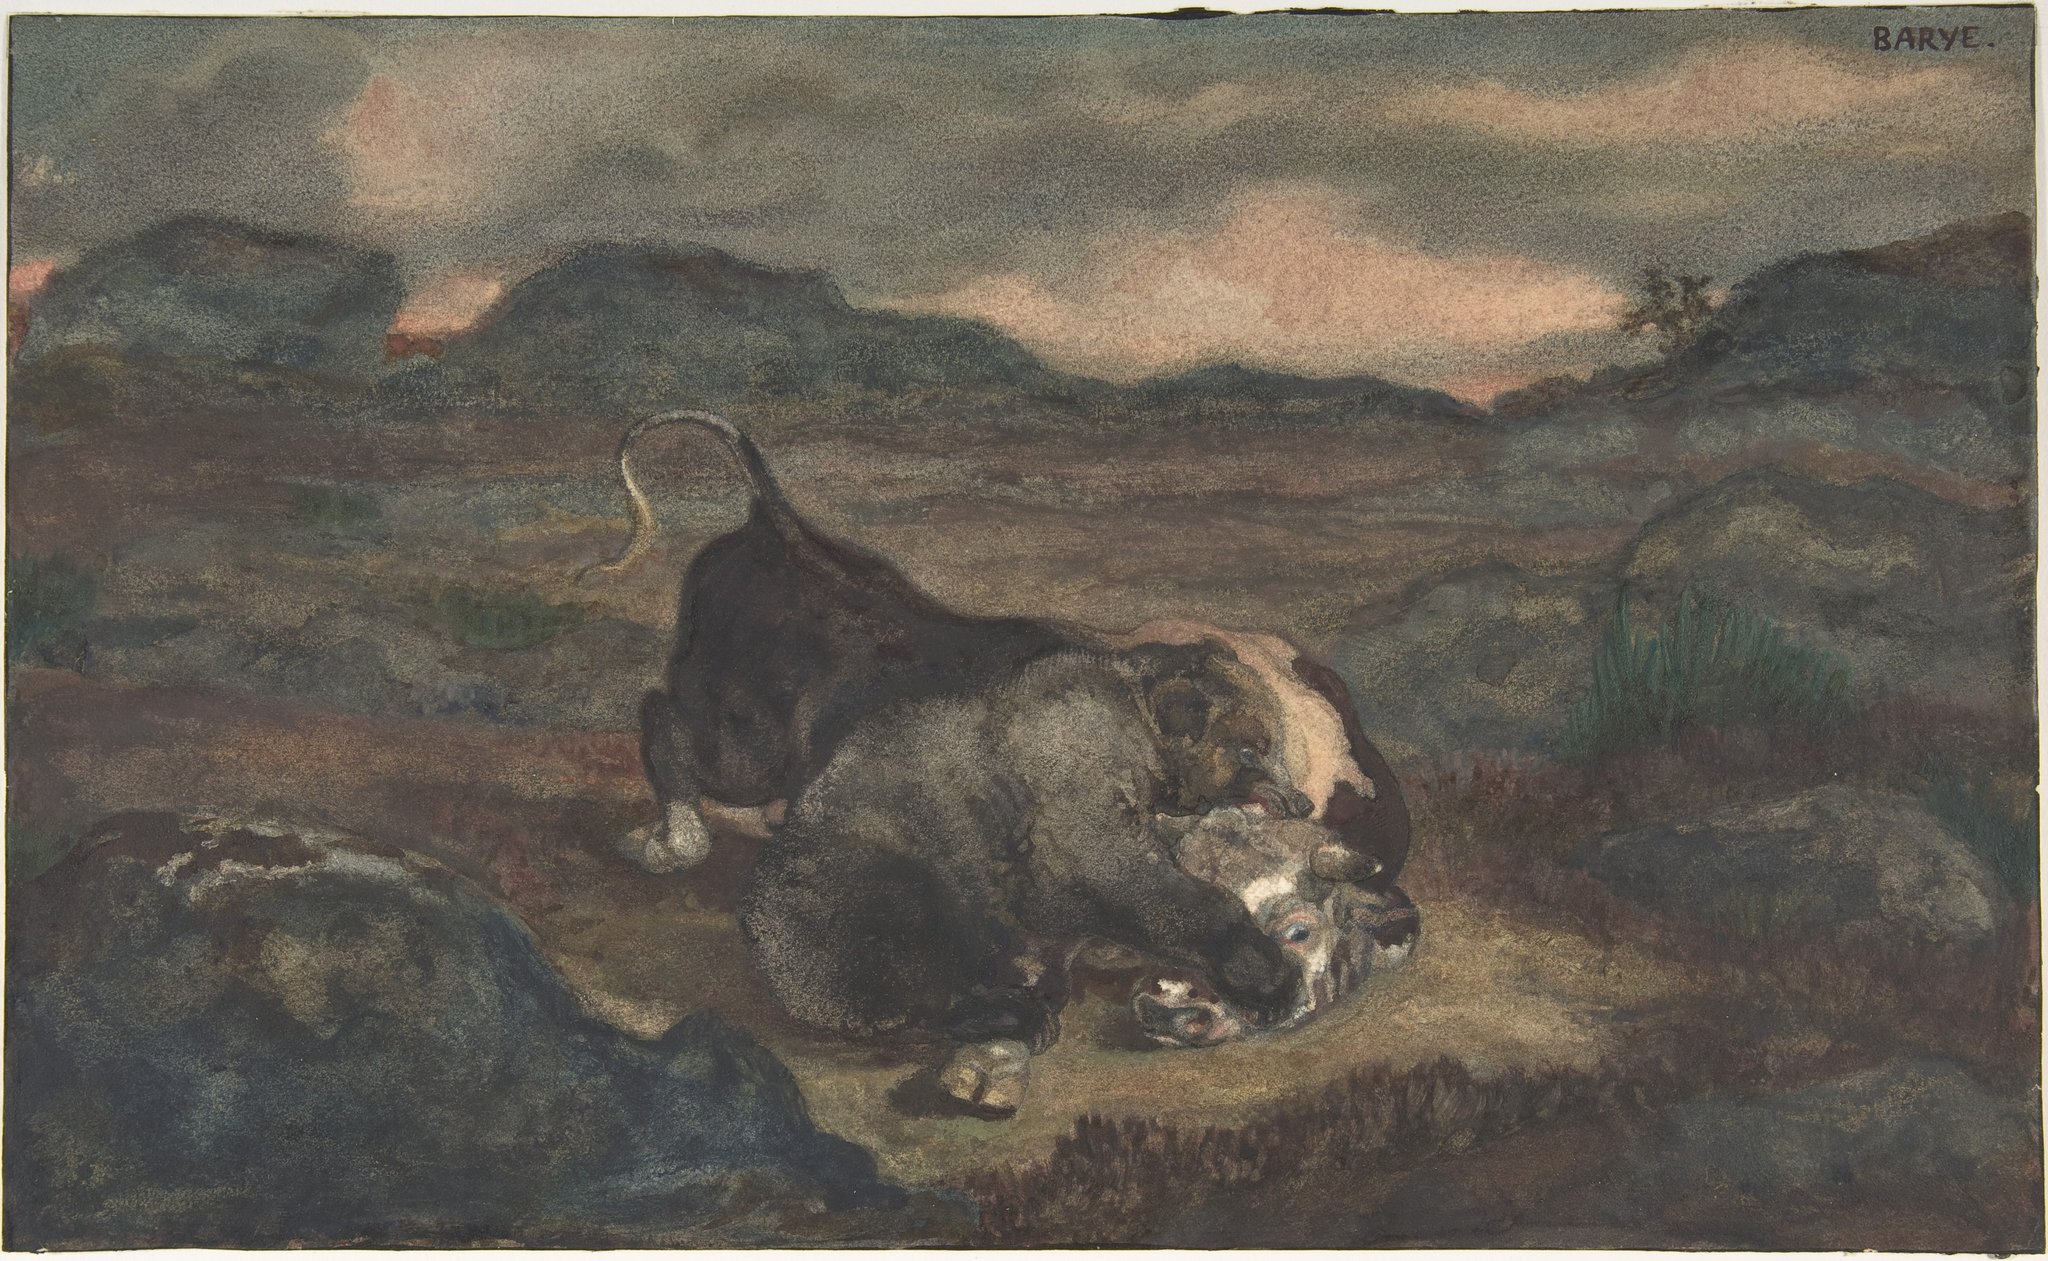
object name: drawing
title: Bear Killing Bull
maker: antoine-louis barye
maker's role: artist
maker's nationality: french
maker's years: 1795-1875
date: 1810-1875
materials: watercolor, paper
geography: france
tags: bears,bulls